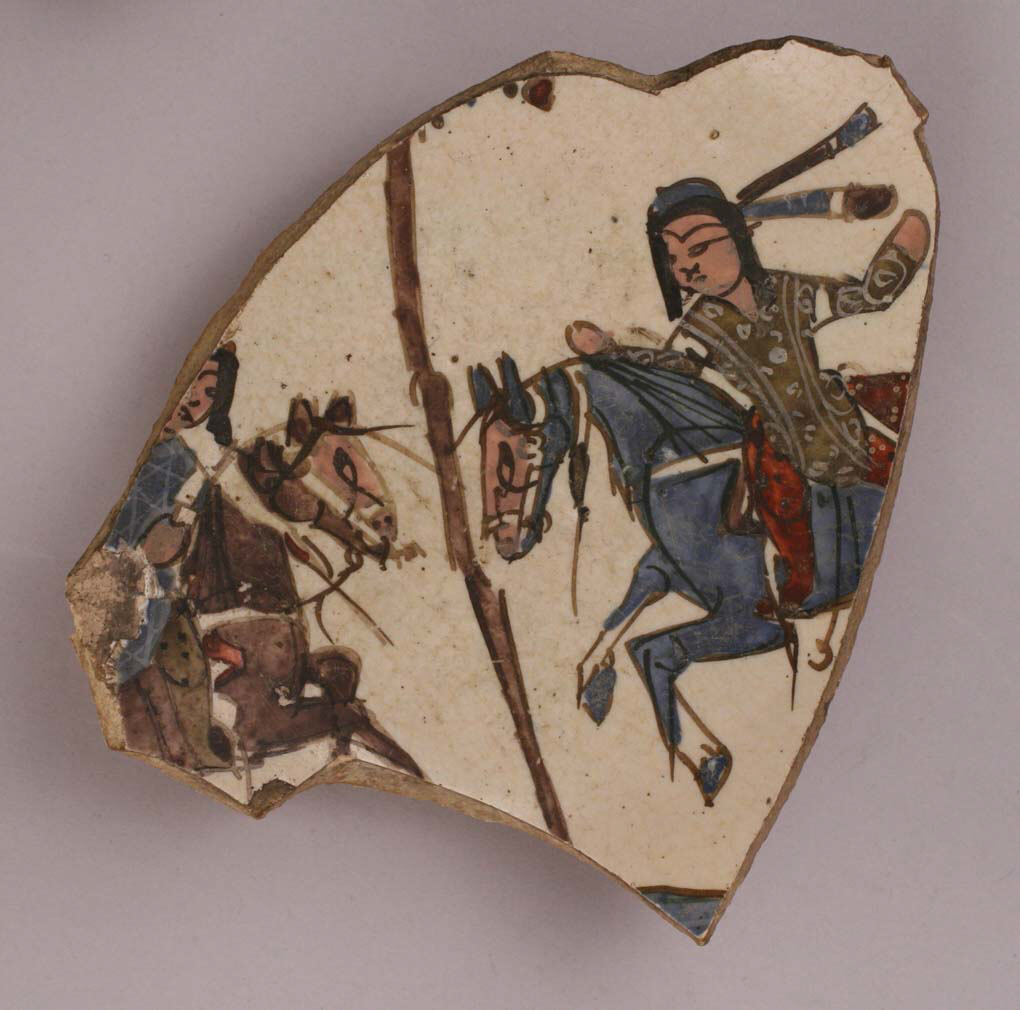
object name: fragment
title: Fragment of a Bowl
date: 1101-1300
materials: stonepaste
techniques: overglaze, painting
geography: iran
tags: men,horses